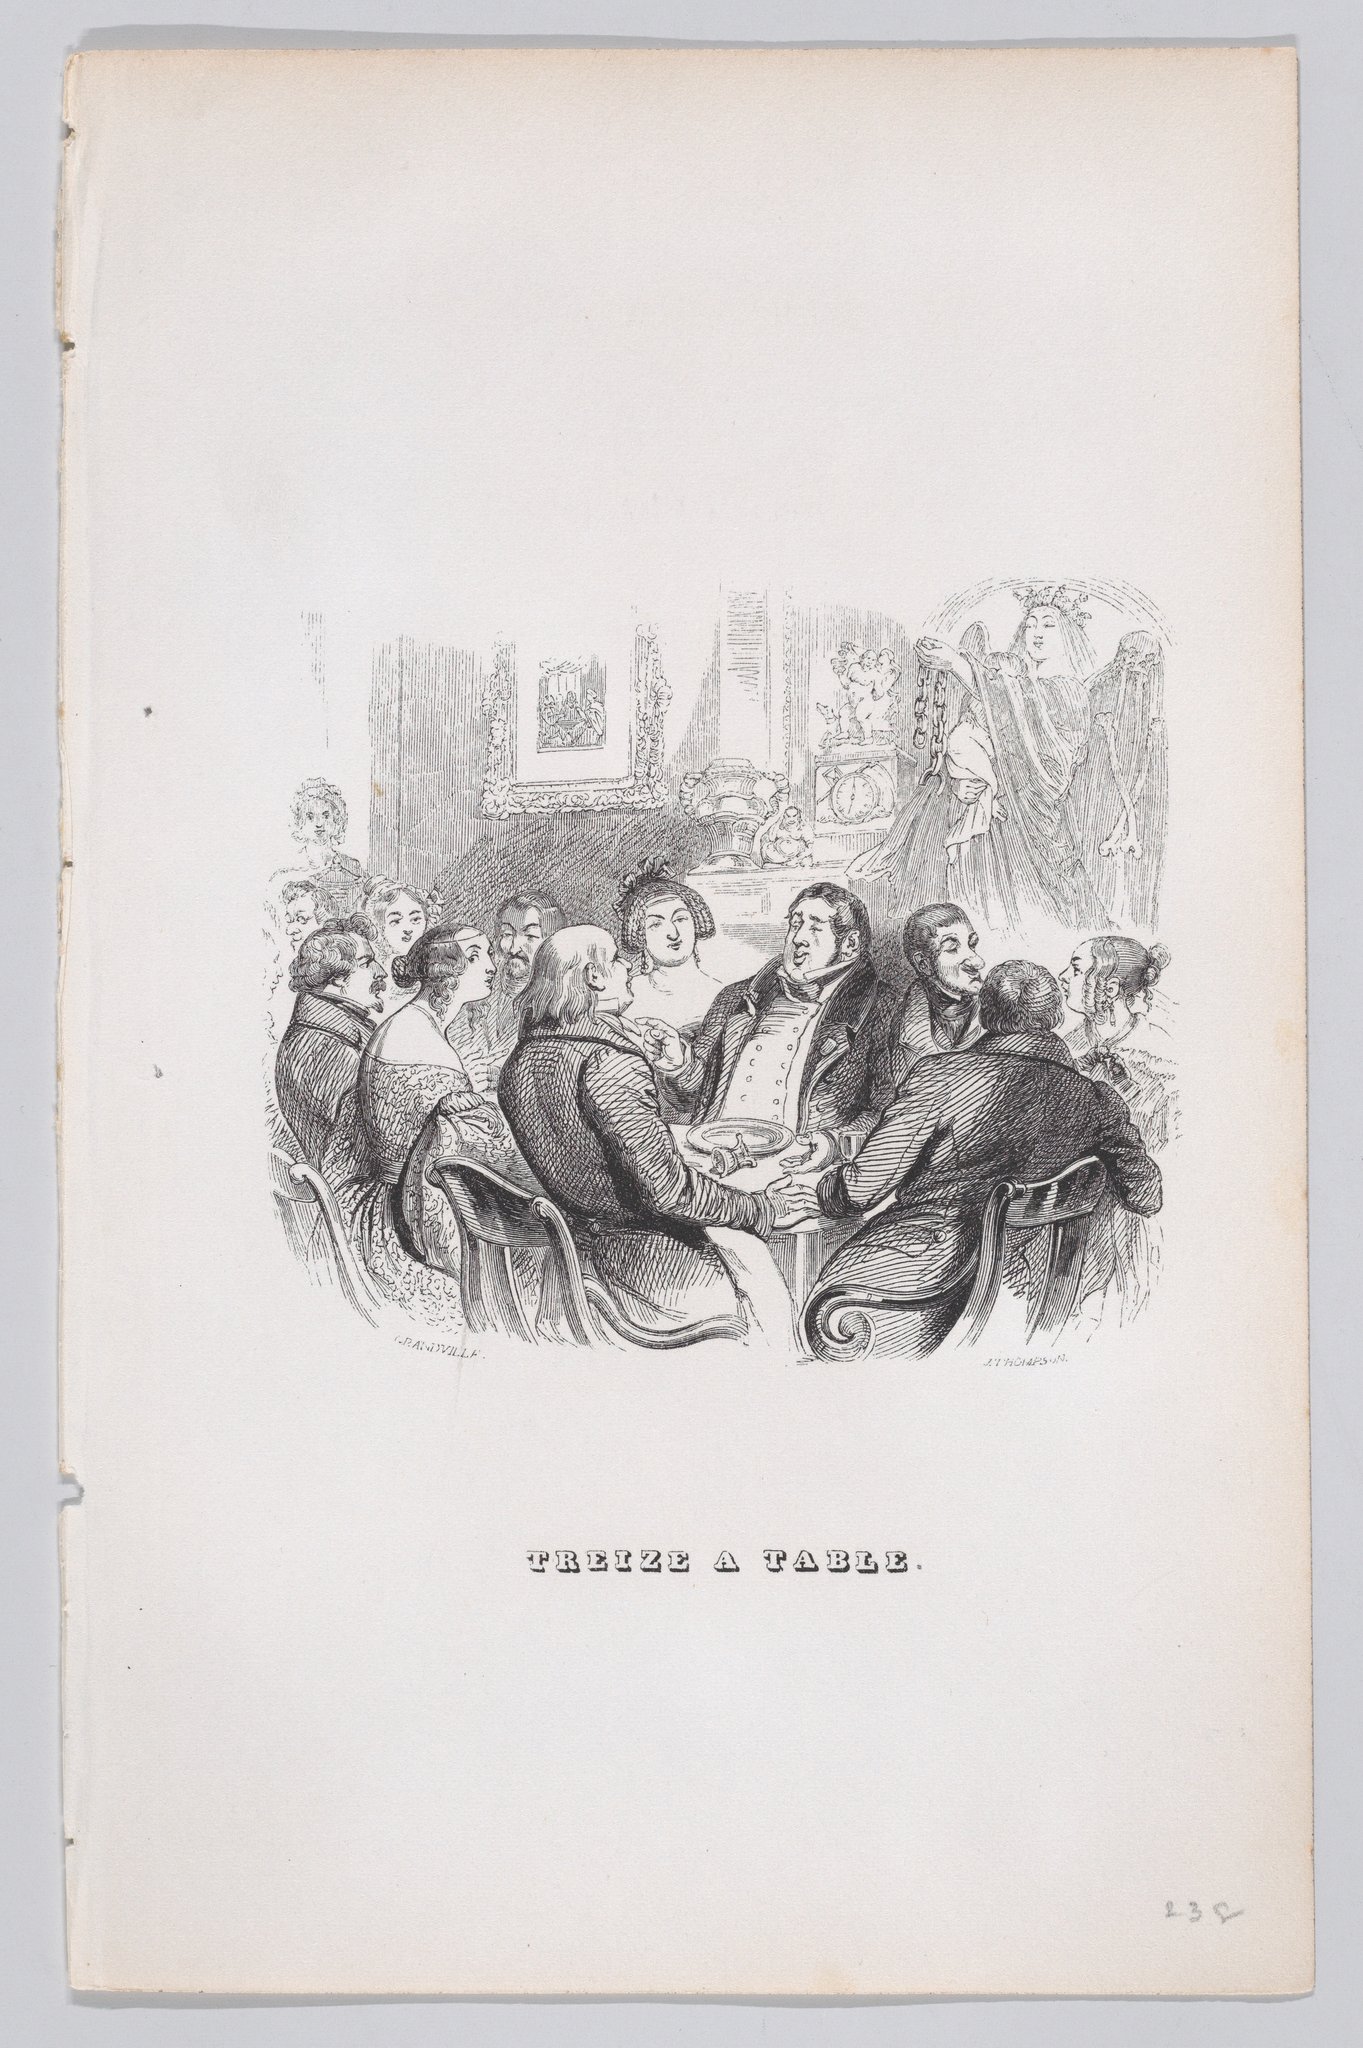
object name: print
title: Thirteen at the Table, from "The Complete Works of Béranger"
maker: j. j. grandville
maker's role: illustrator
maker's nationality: french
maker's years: 1803-1847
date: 1836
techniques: engraving